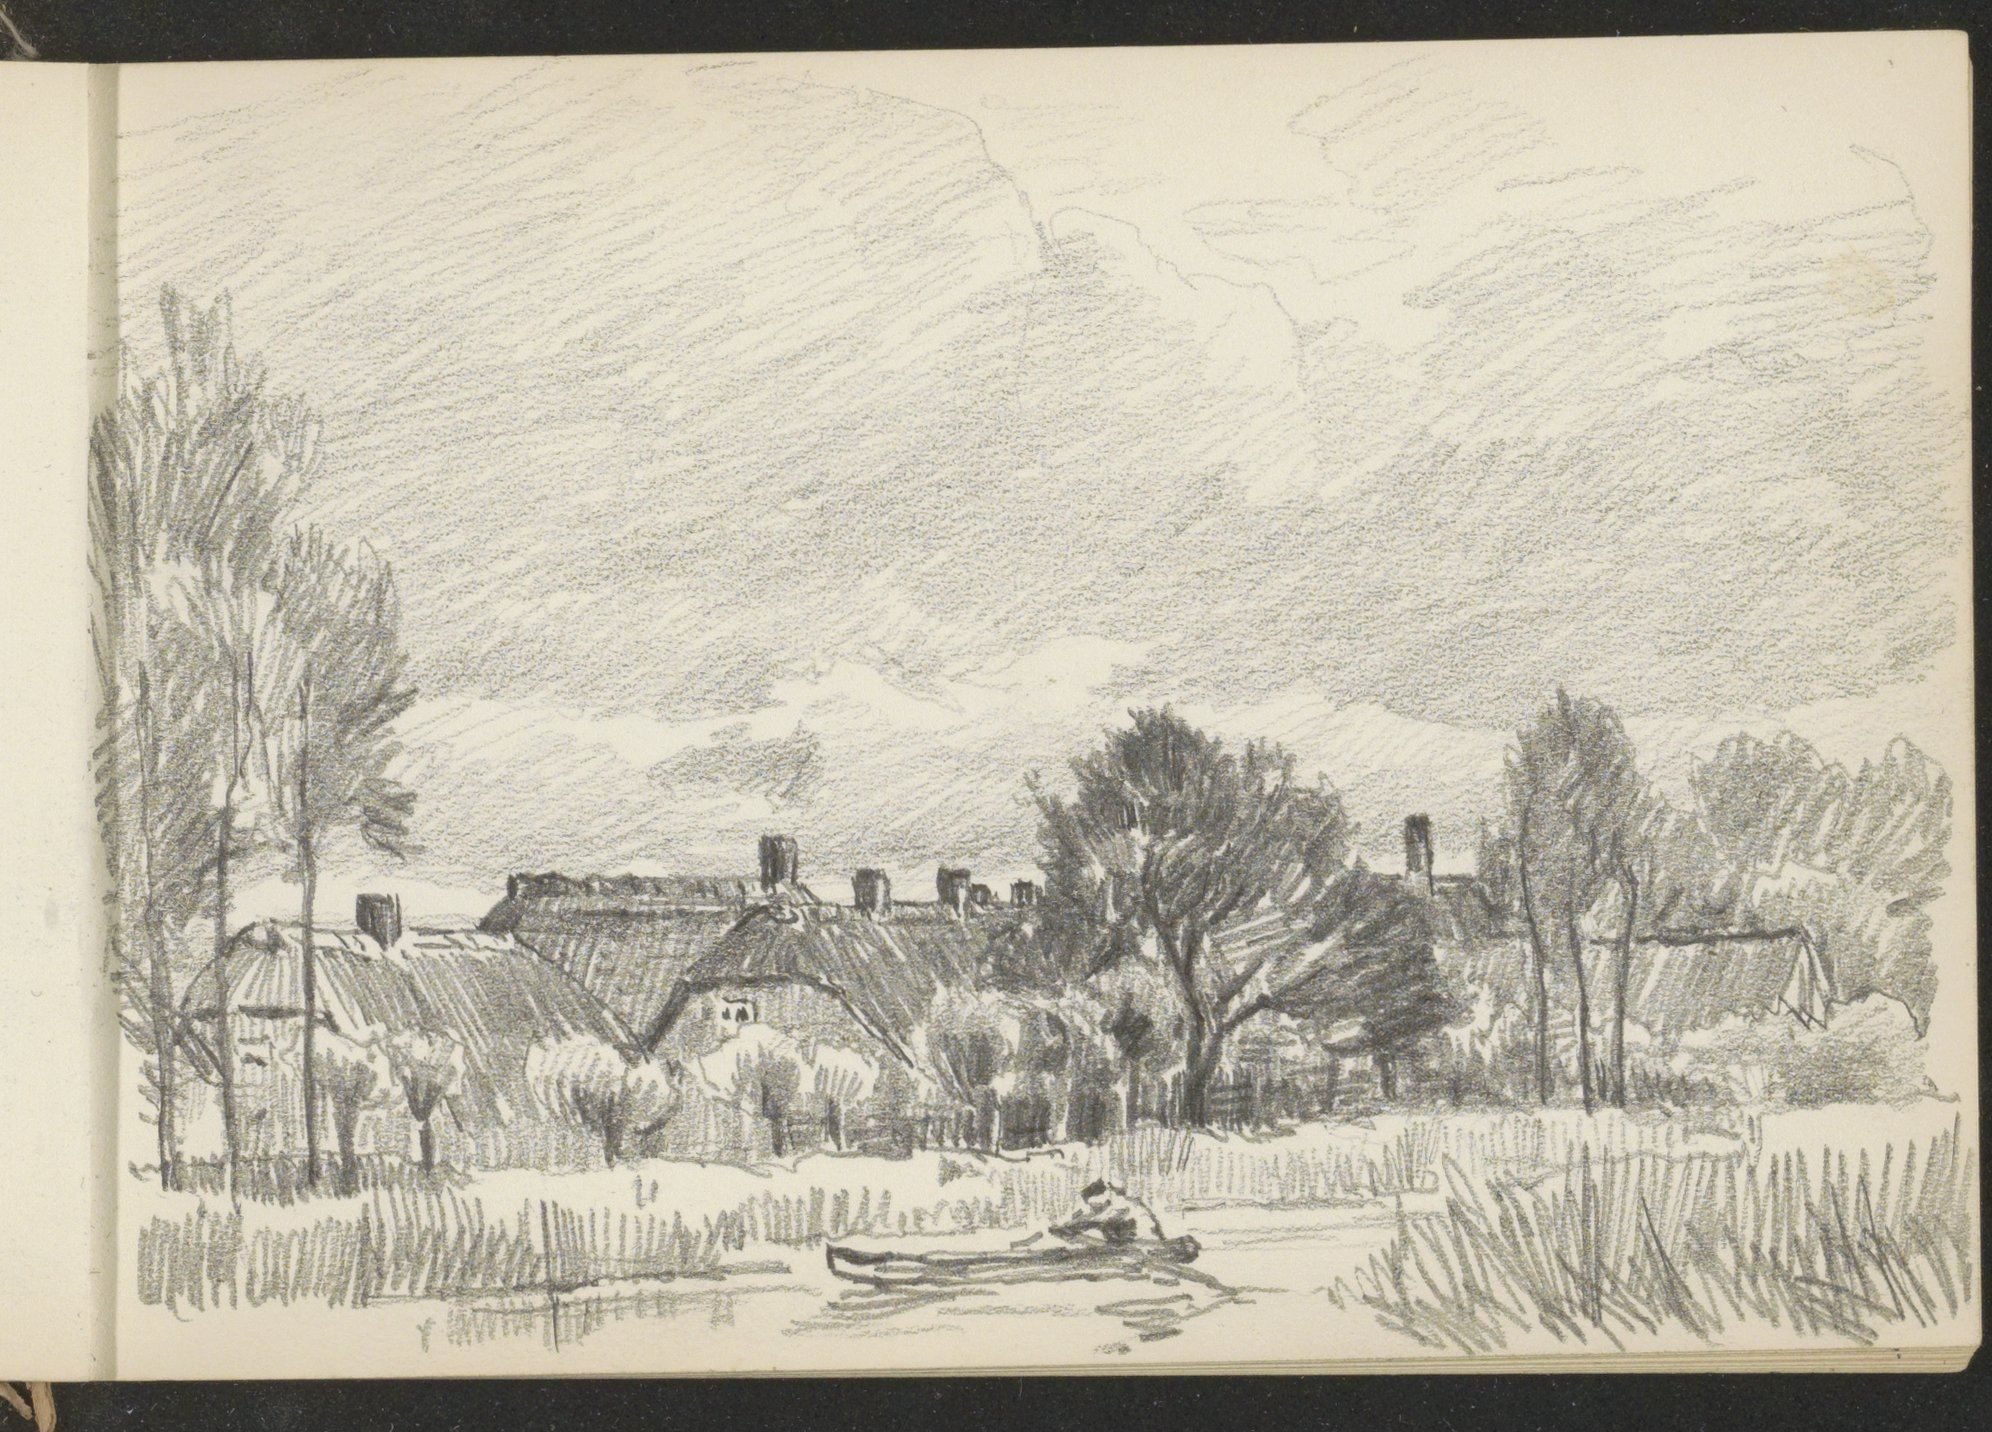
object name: sketchbook leaf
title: Dorp aan een waterkant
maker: alexander shilling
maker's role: draughtsman, print maker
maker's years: 1859-1937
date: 1907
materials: paper, pencil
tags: landscapes with waters, waterscapes, seascapes (in the temperate zone), village, rowing-boat, canoe, etc.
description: Op het water een figuur in een roeiboot. Blad 16 recto uit een schetsboek met 24 bladen.